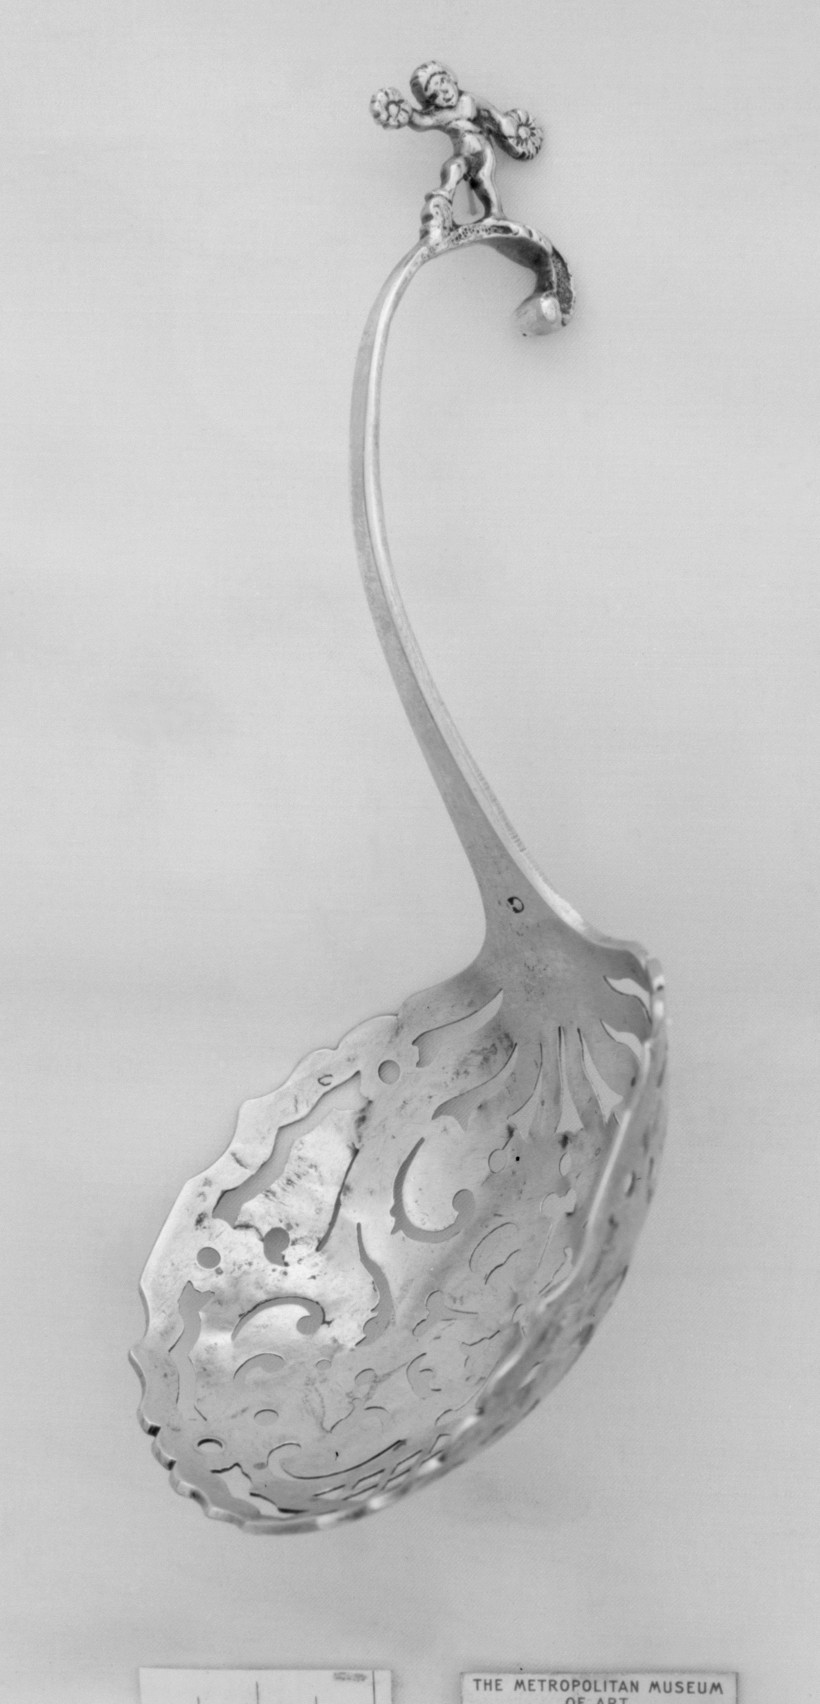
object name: sugar spoon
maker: jan pereboom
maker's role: maker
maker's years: 1725-1805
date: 1776-1800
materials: silver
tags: human figures